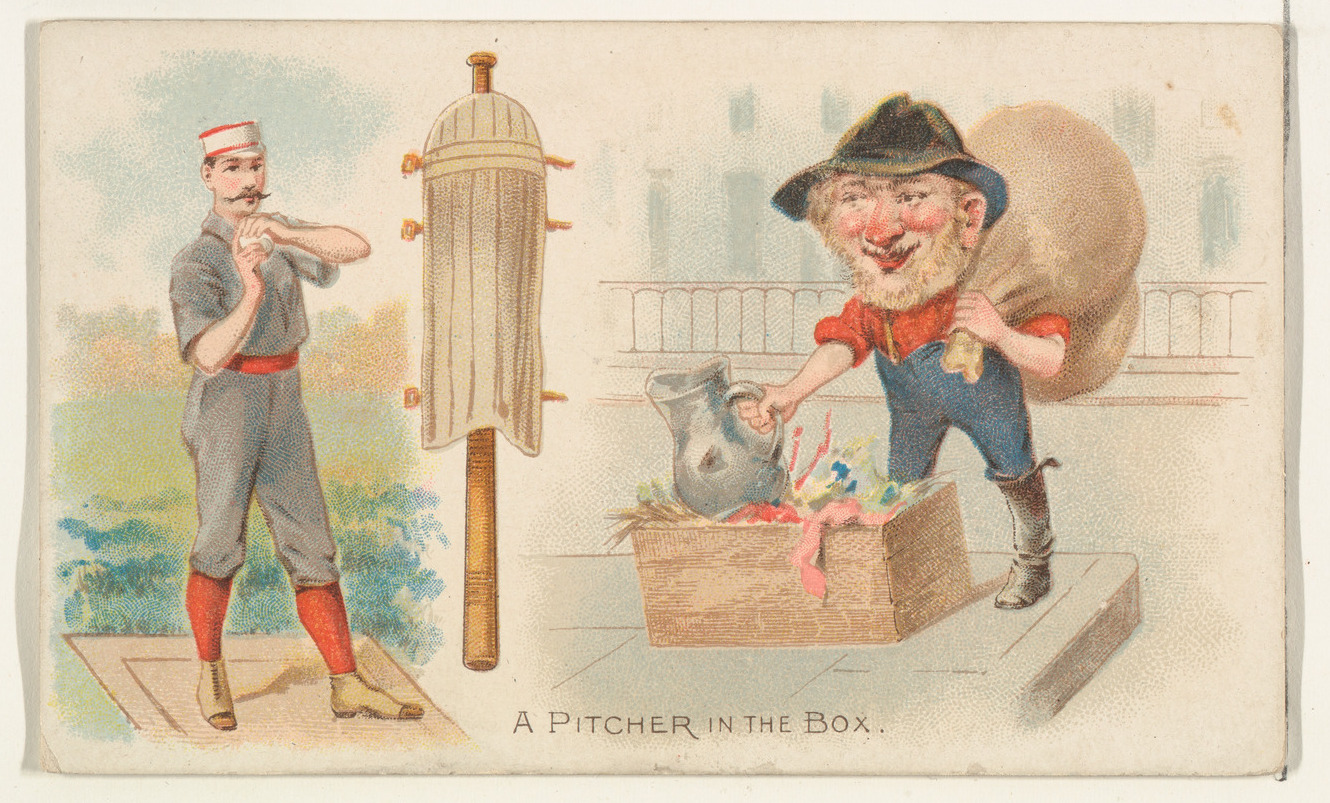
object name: print, baseball card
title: A Pitcher in the Box, from the Talk of the Diamond set (N135) issued by Duke Sons & Co., a branch of the American Tobacco Company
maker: w. duke, sons & co.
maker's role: publisher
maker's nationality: american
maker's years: 1870-1920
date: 1888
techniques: color lithograph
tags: men,pitchers